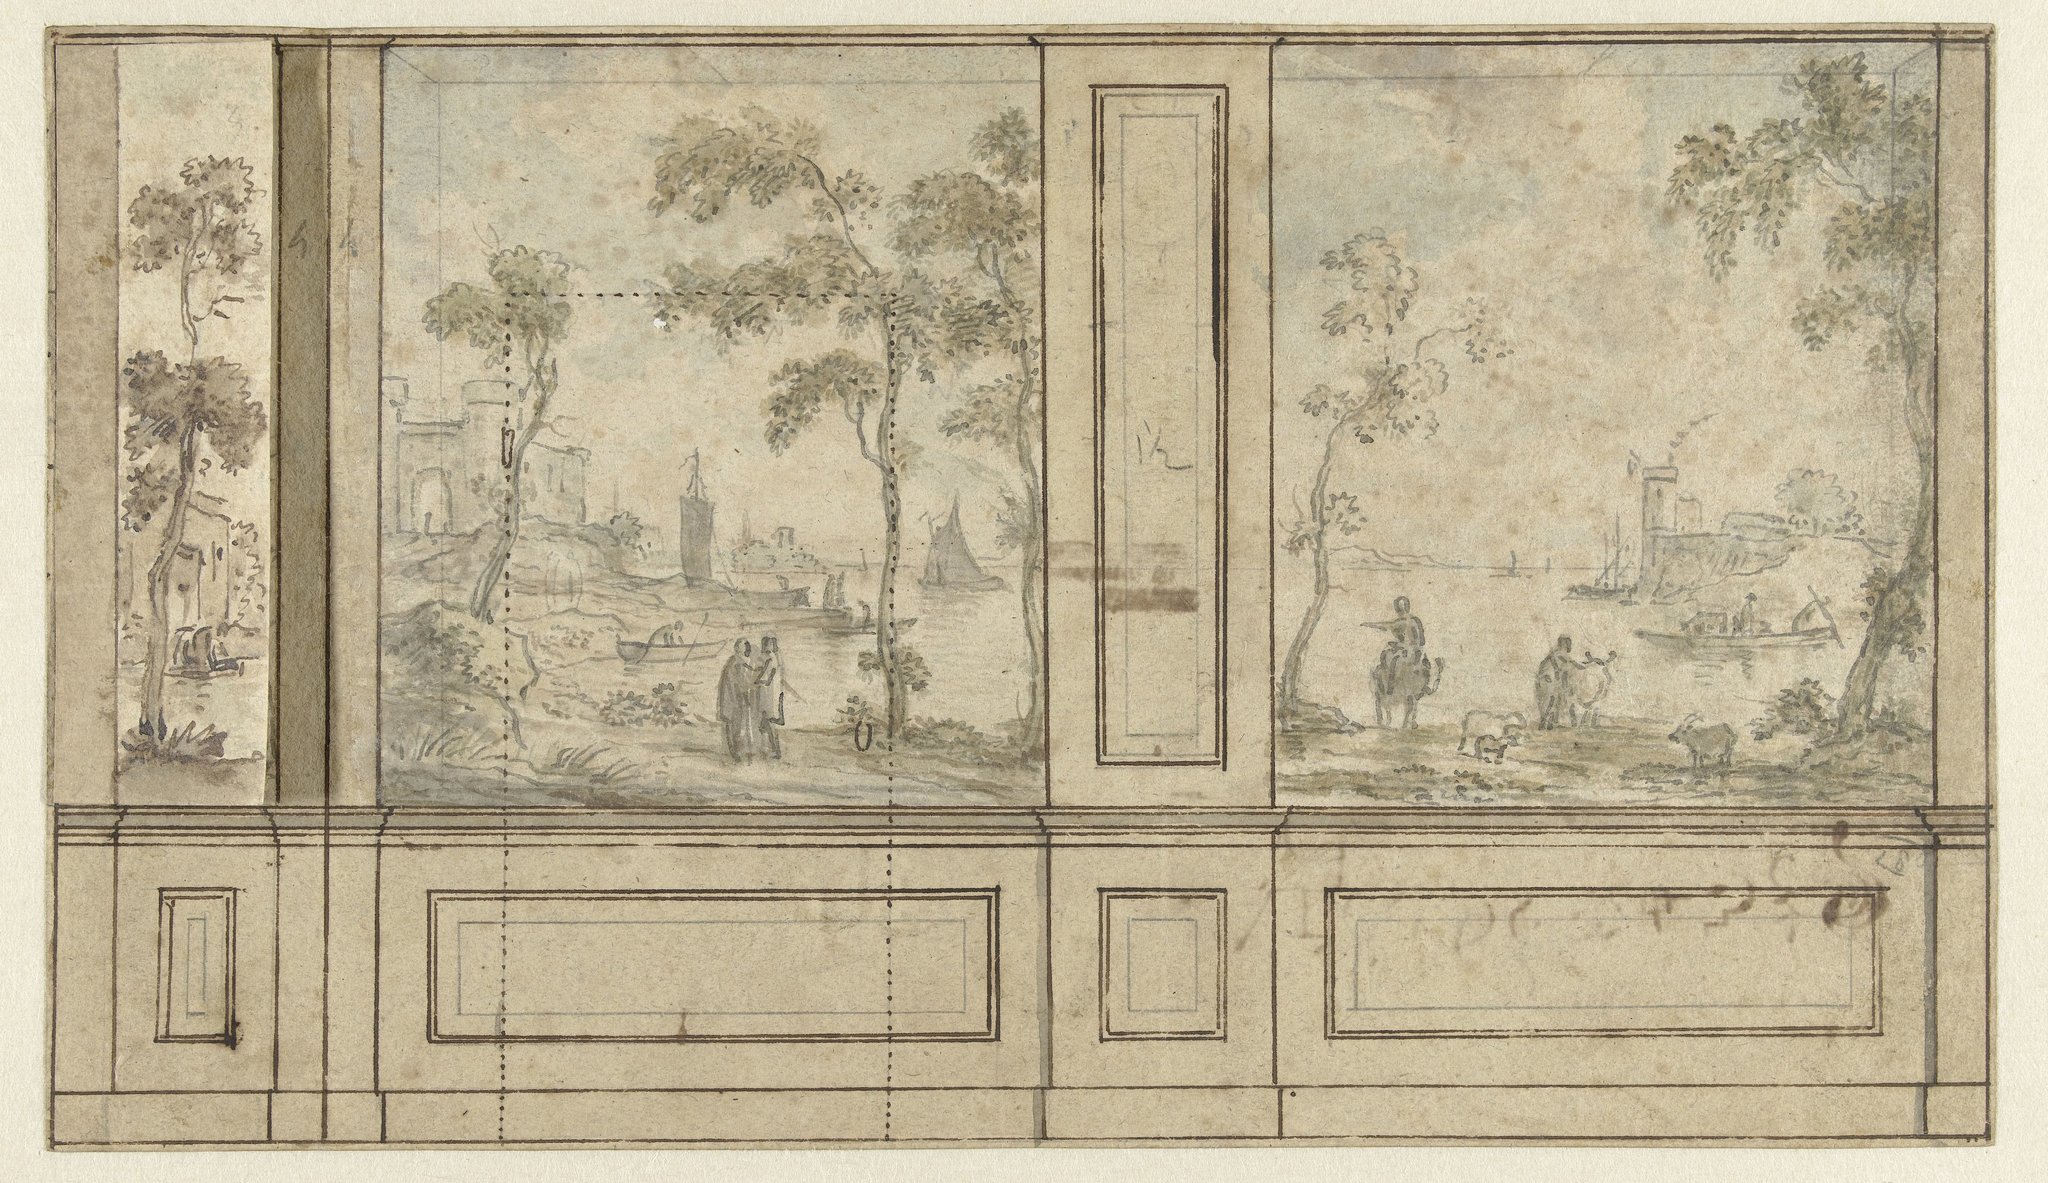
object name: design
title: Ontwerp voor kamerwand met drie behangselpanelen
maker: jurriaan andriessen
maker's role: draughtsman, painter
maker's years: 1742-1819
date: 1752-1819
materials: graphite, ink, paper, watercolor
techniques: brush, pen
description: Ontwerp voor kamerwand met drie behangselpanelen, waarvan de linker het smalst.